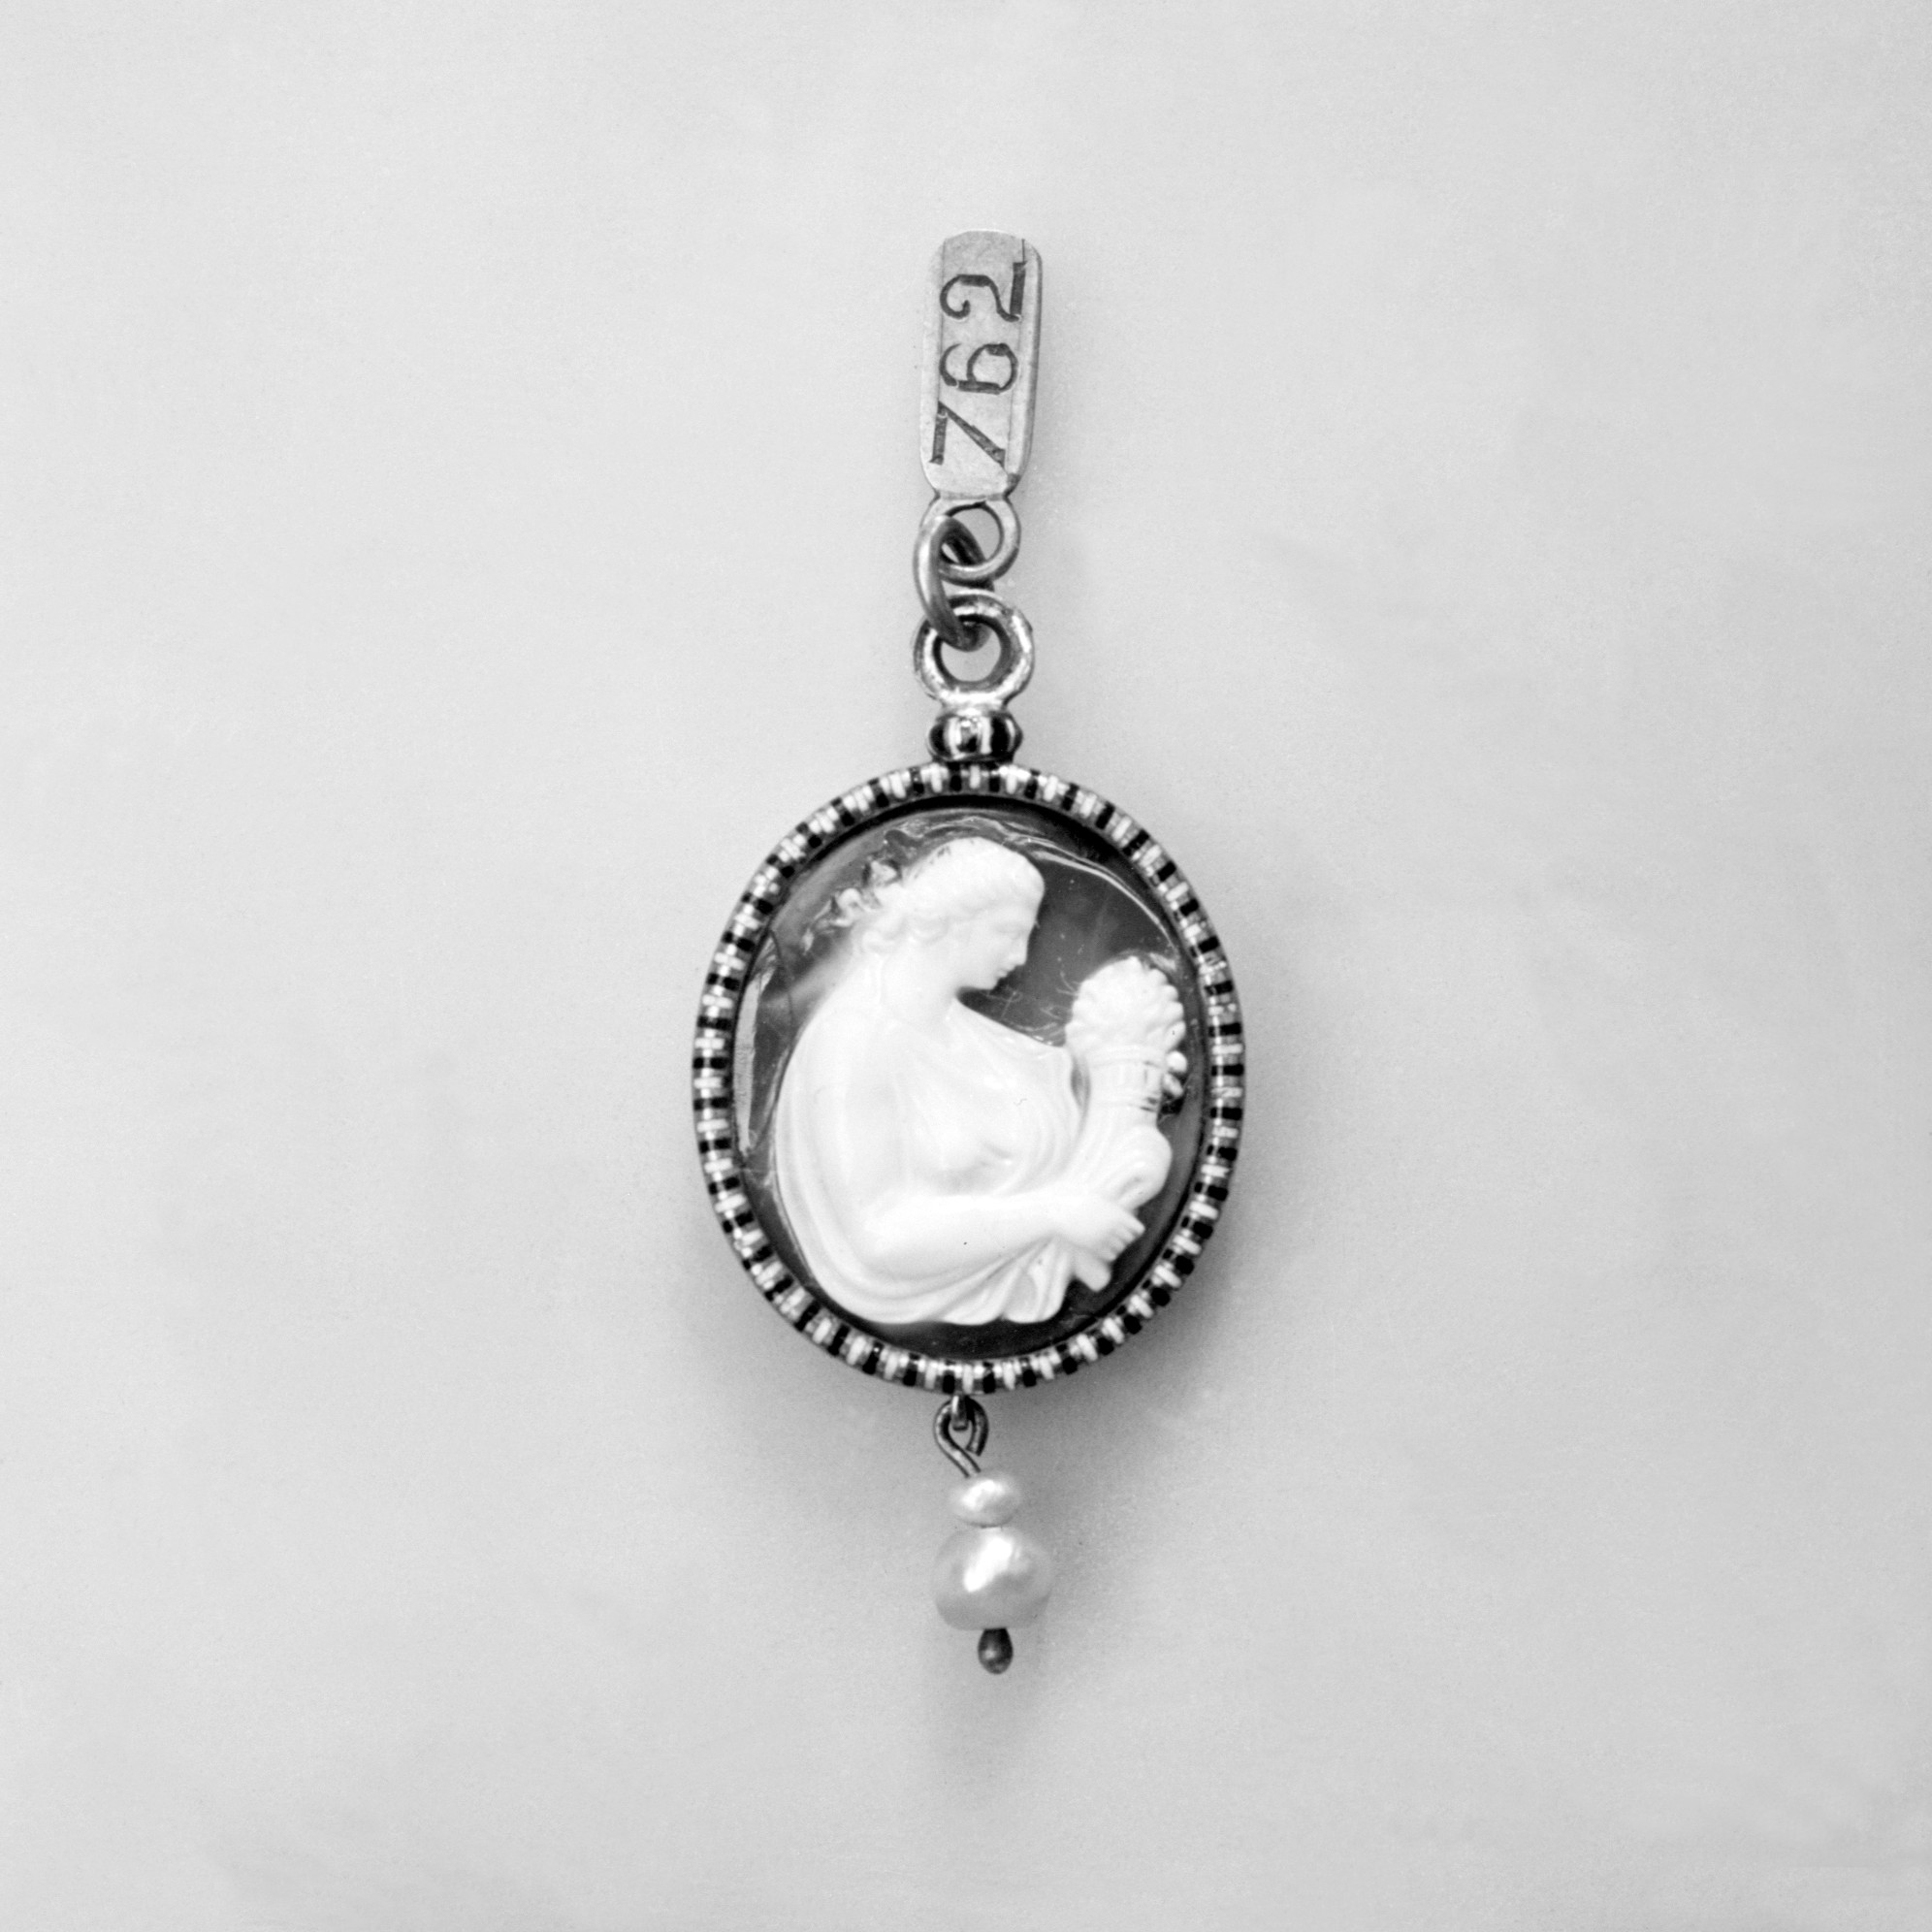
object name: cameo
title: Pomona with the cornucopia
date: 1560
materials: enamel, gold, onyx, pearl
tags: cornucopia,goddess